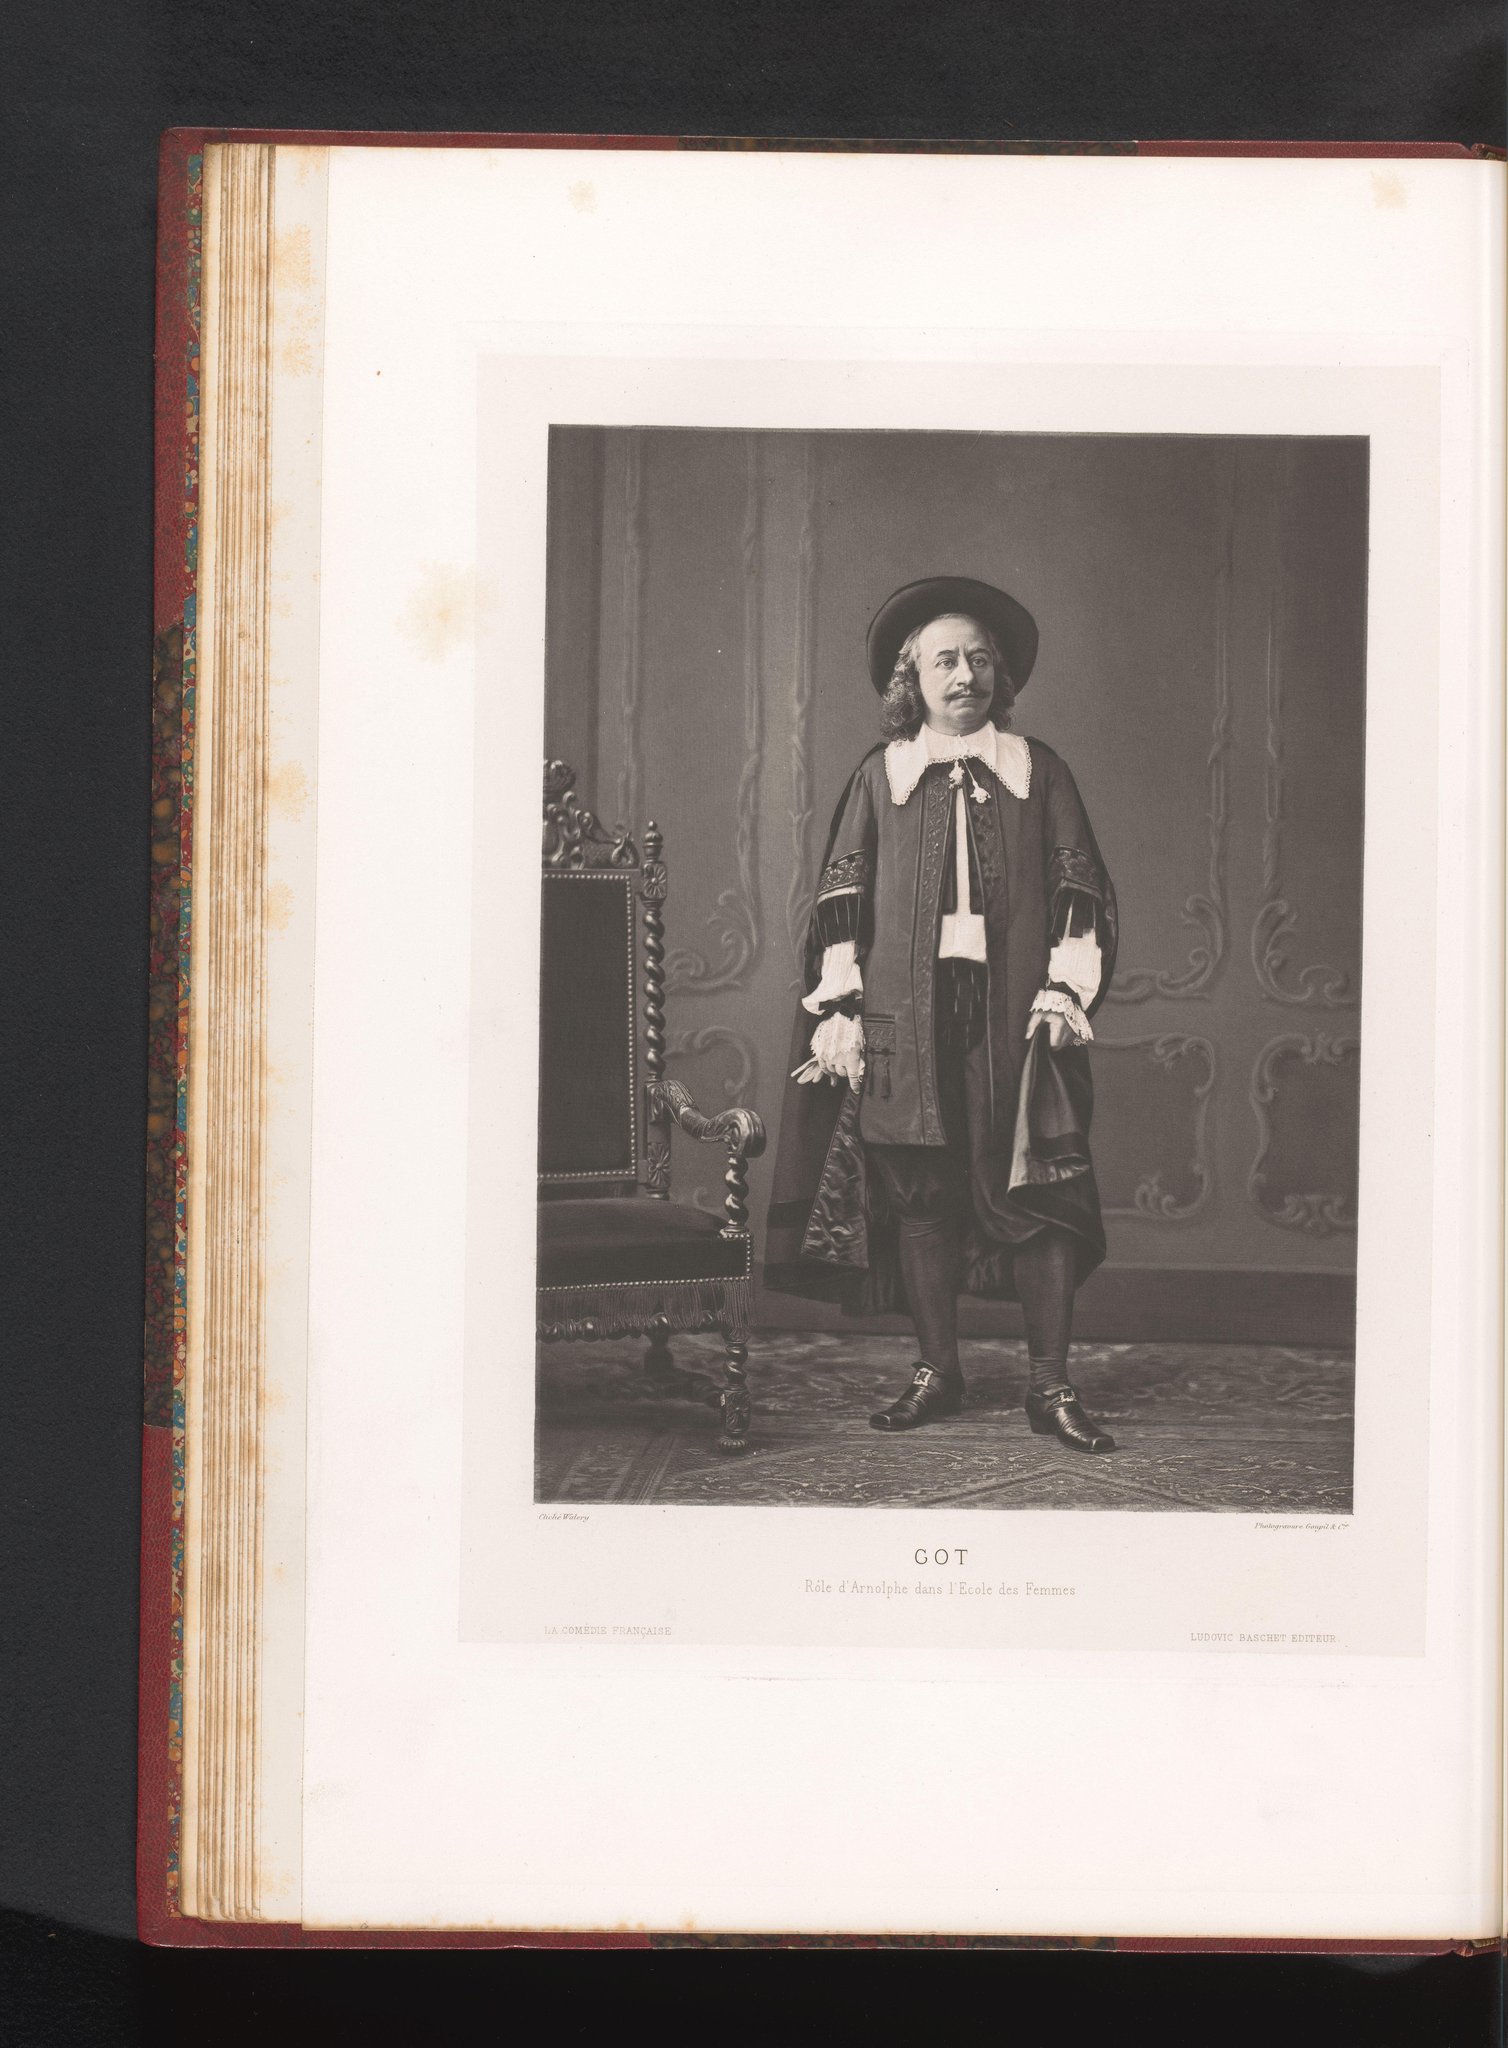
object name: page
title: Portret van François Jules Edmond Got in de rol van Arnolphe in L'Écolde des Femmes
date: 1875-1880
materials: paper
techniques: photoaquatint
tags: historical persons, portrait of actor, actress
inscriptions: inscription: ‘LA COMÉDIE FRANÇAISE’